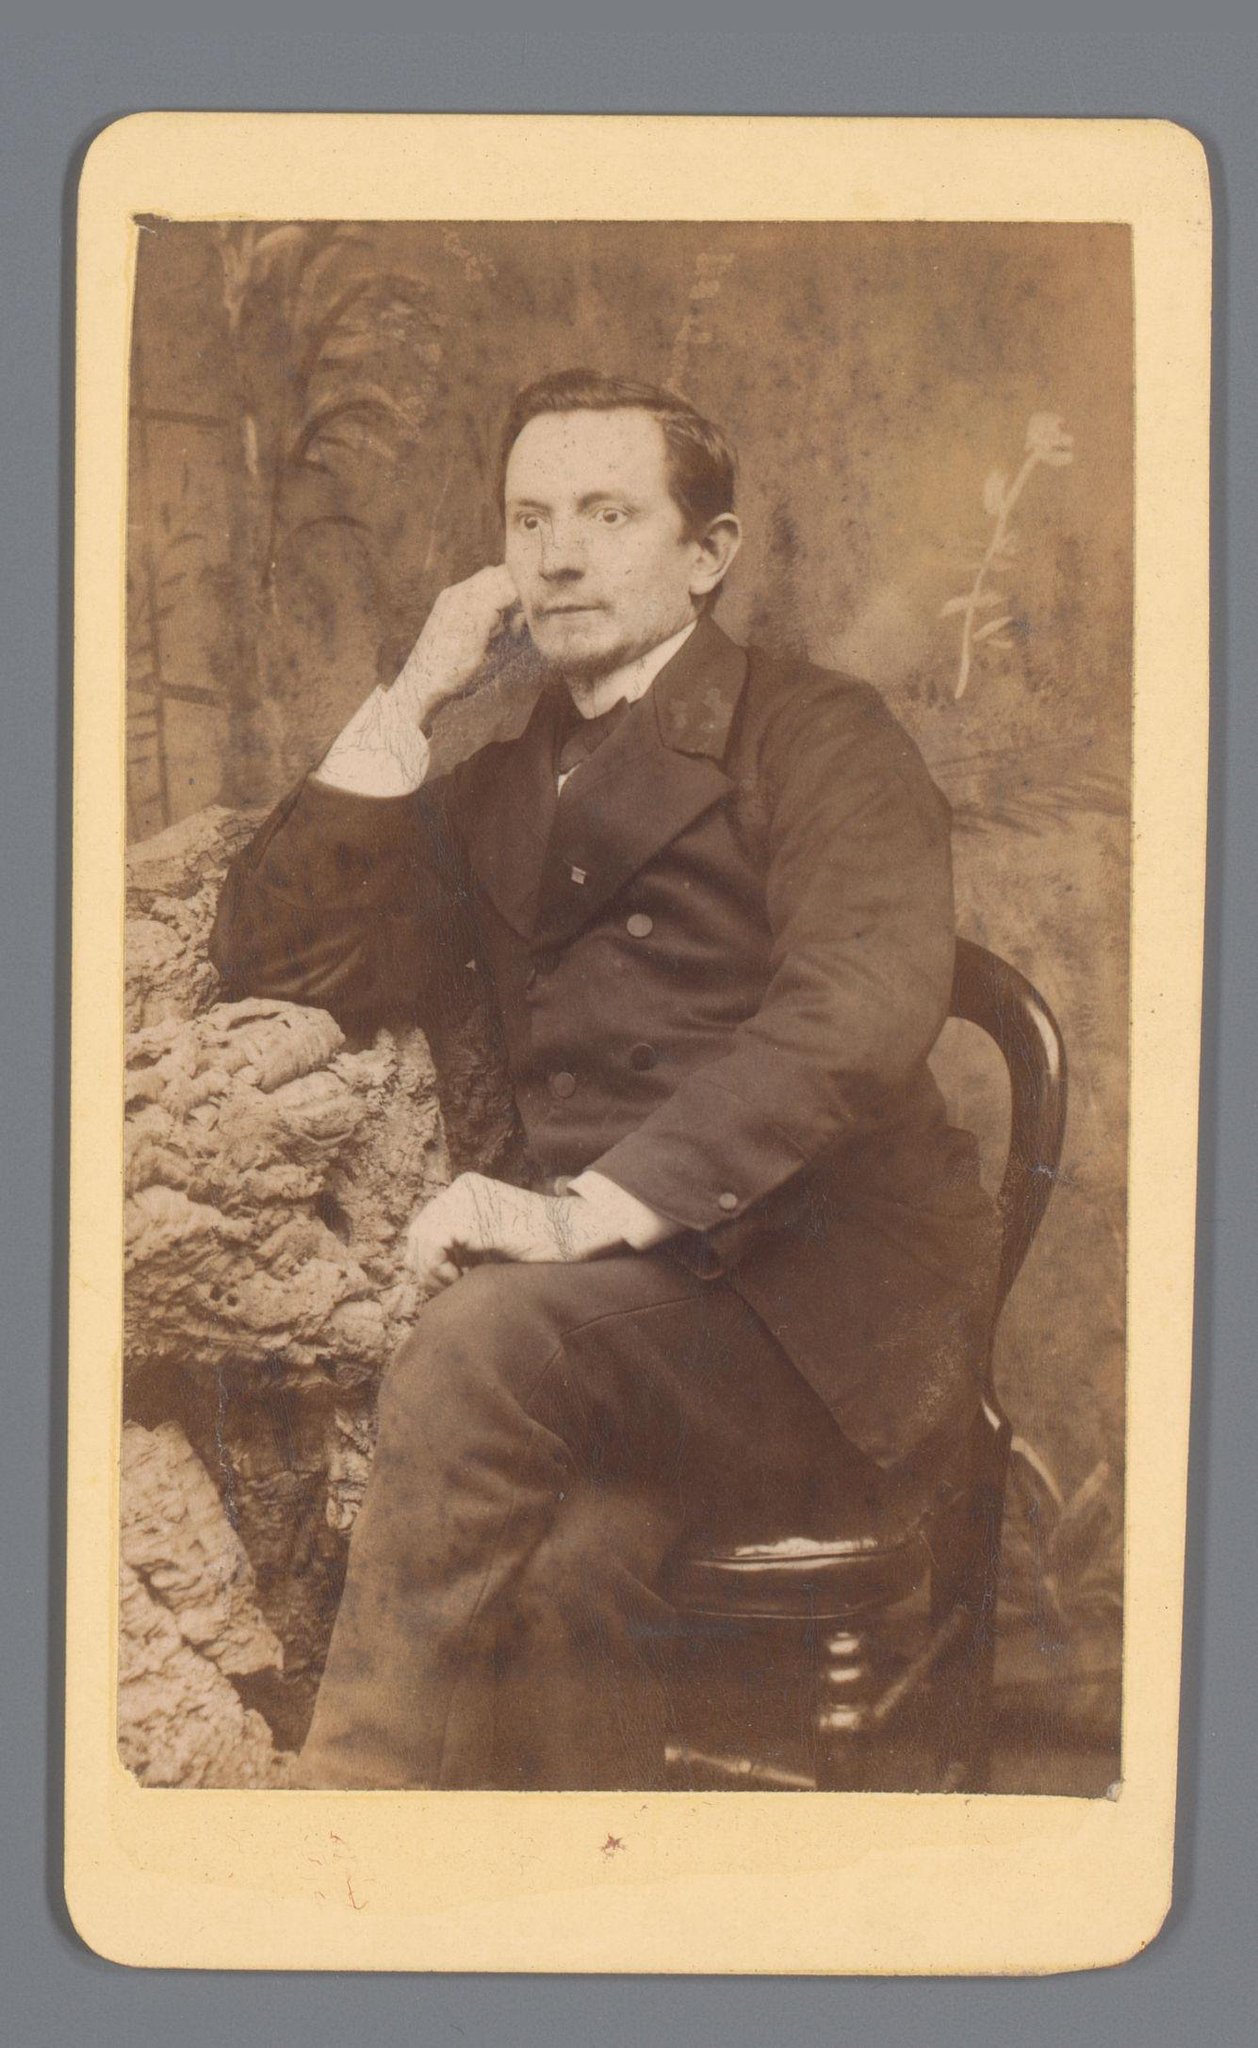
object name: carte de visite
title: Portret van een onbekende man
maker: Anonymous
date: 1855-1885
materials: cardboard, paper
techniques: albumen print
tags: adult man, anonymous historical person portrayed